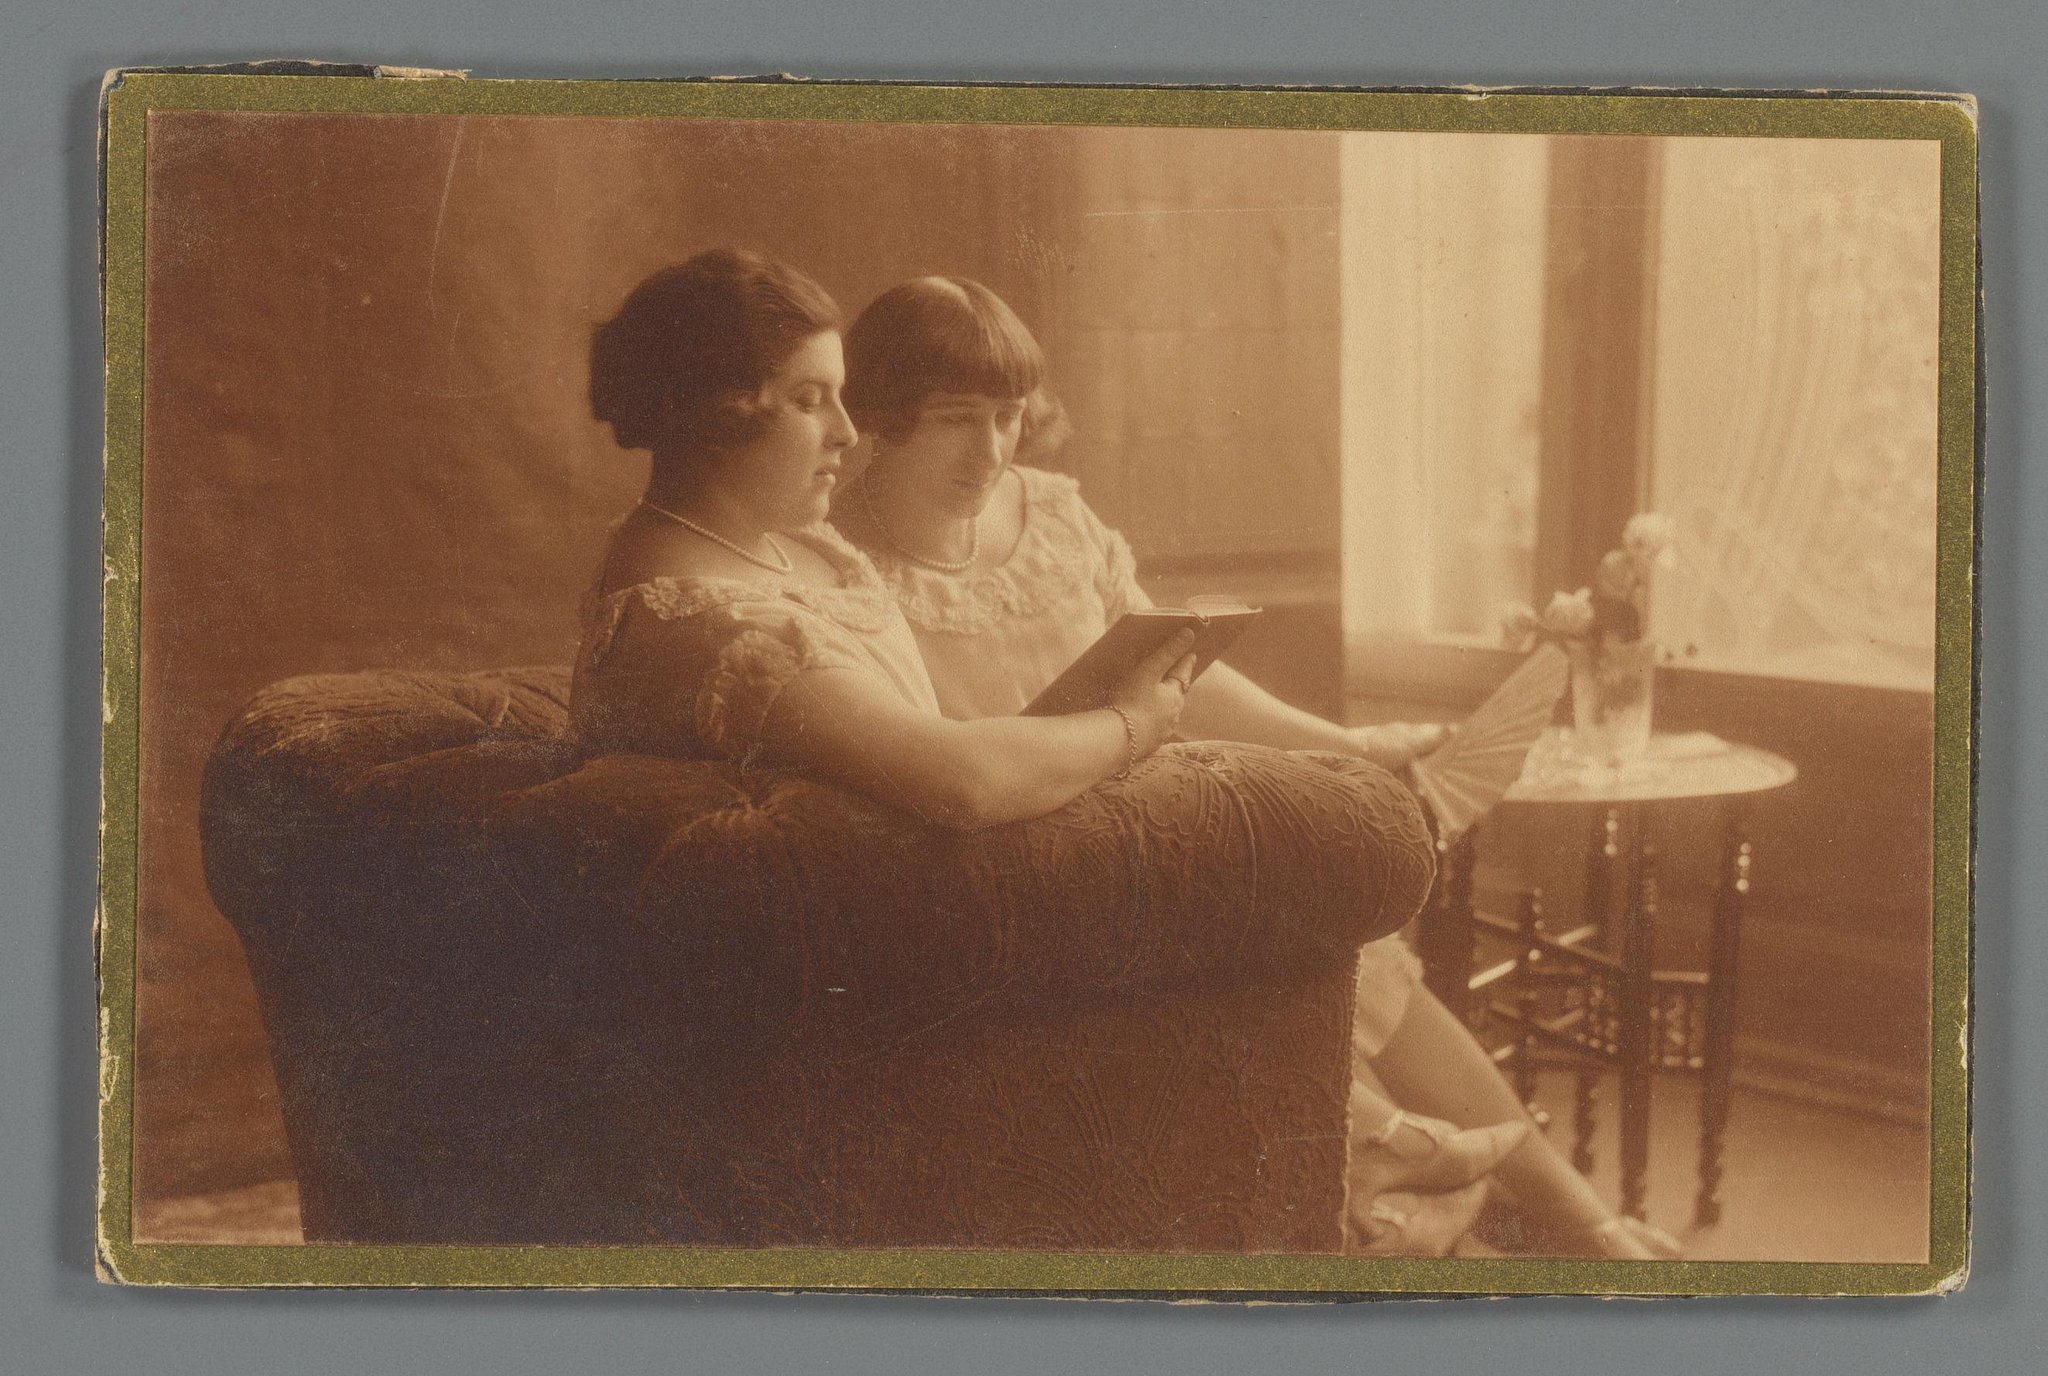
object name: photograph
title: Portret van Henny en Cato Merks lezend op de bank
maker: arie dettmeijer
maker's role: fotograaf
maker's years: 1884-1967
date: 1918-1926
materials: paper, cardboard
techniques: gelatin silver print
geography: schiedam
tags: reading, historical persons - bb - woman, portrait of cabaret-artiste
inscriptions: inscription: ‘Henny en Cato Merks’